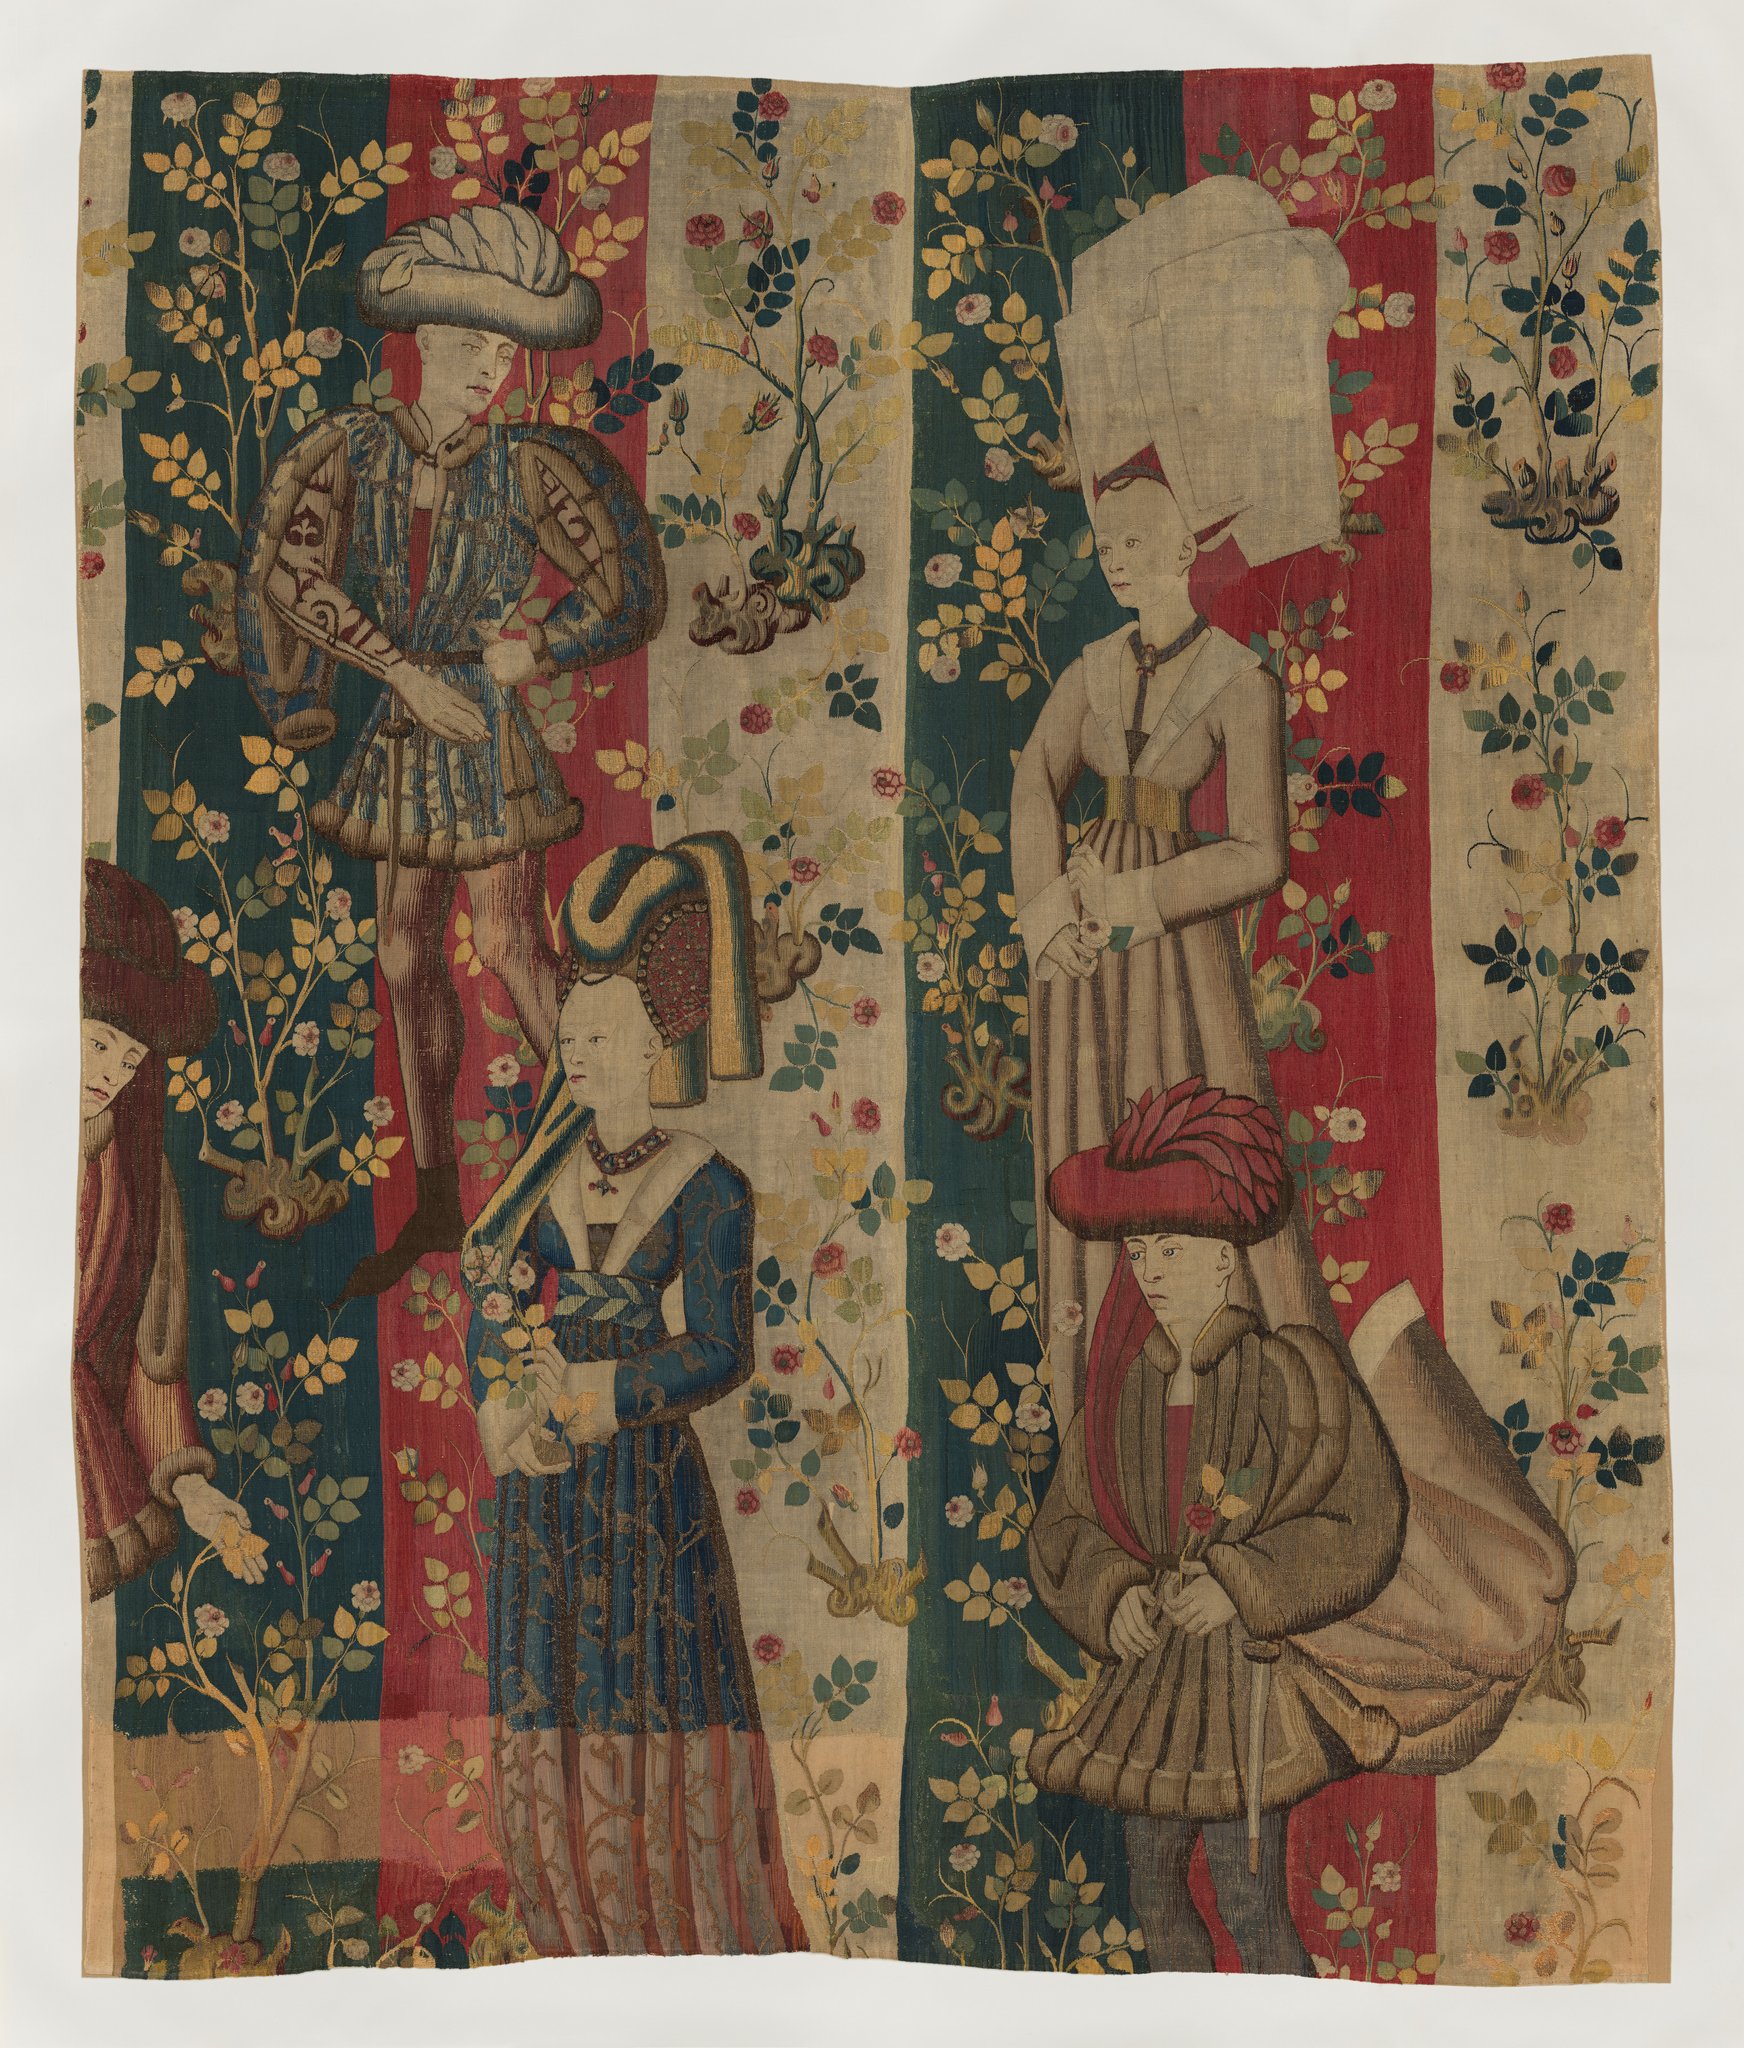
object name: tapestry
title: Courtiers in a Rose Garden: Two Ladies and Two Gentlemen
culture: south netherlandish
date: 1440-1450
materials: silk, wool, thread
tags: men,women,roses